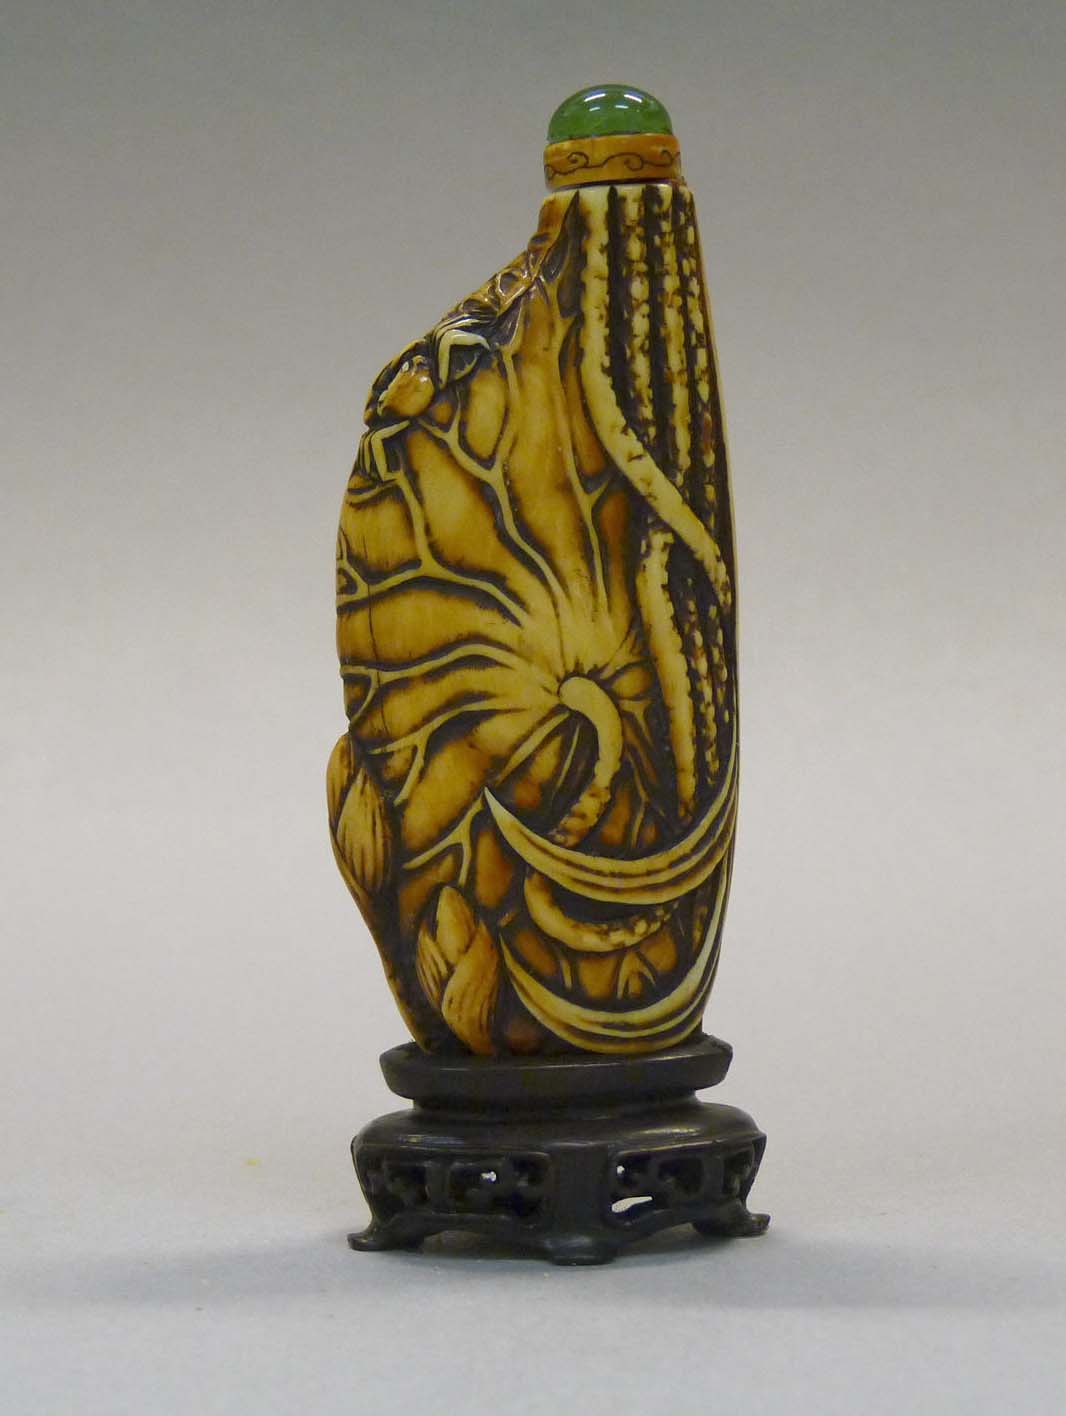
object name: snuff bottle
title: Snuff Bottle with Stopper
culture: chinese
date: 1700-1795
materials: glass, ivory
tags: lotuses